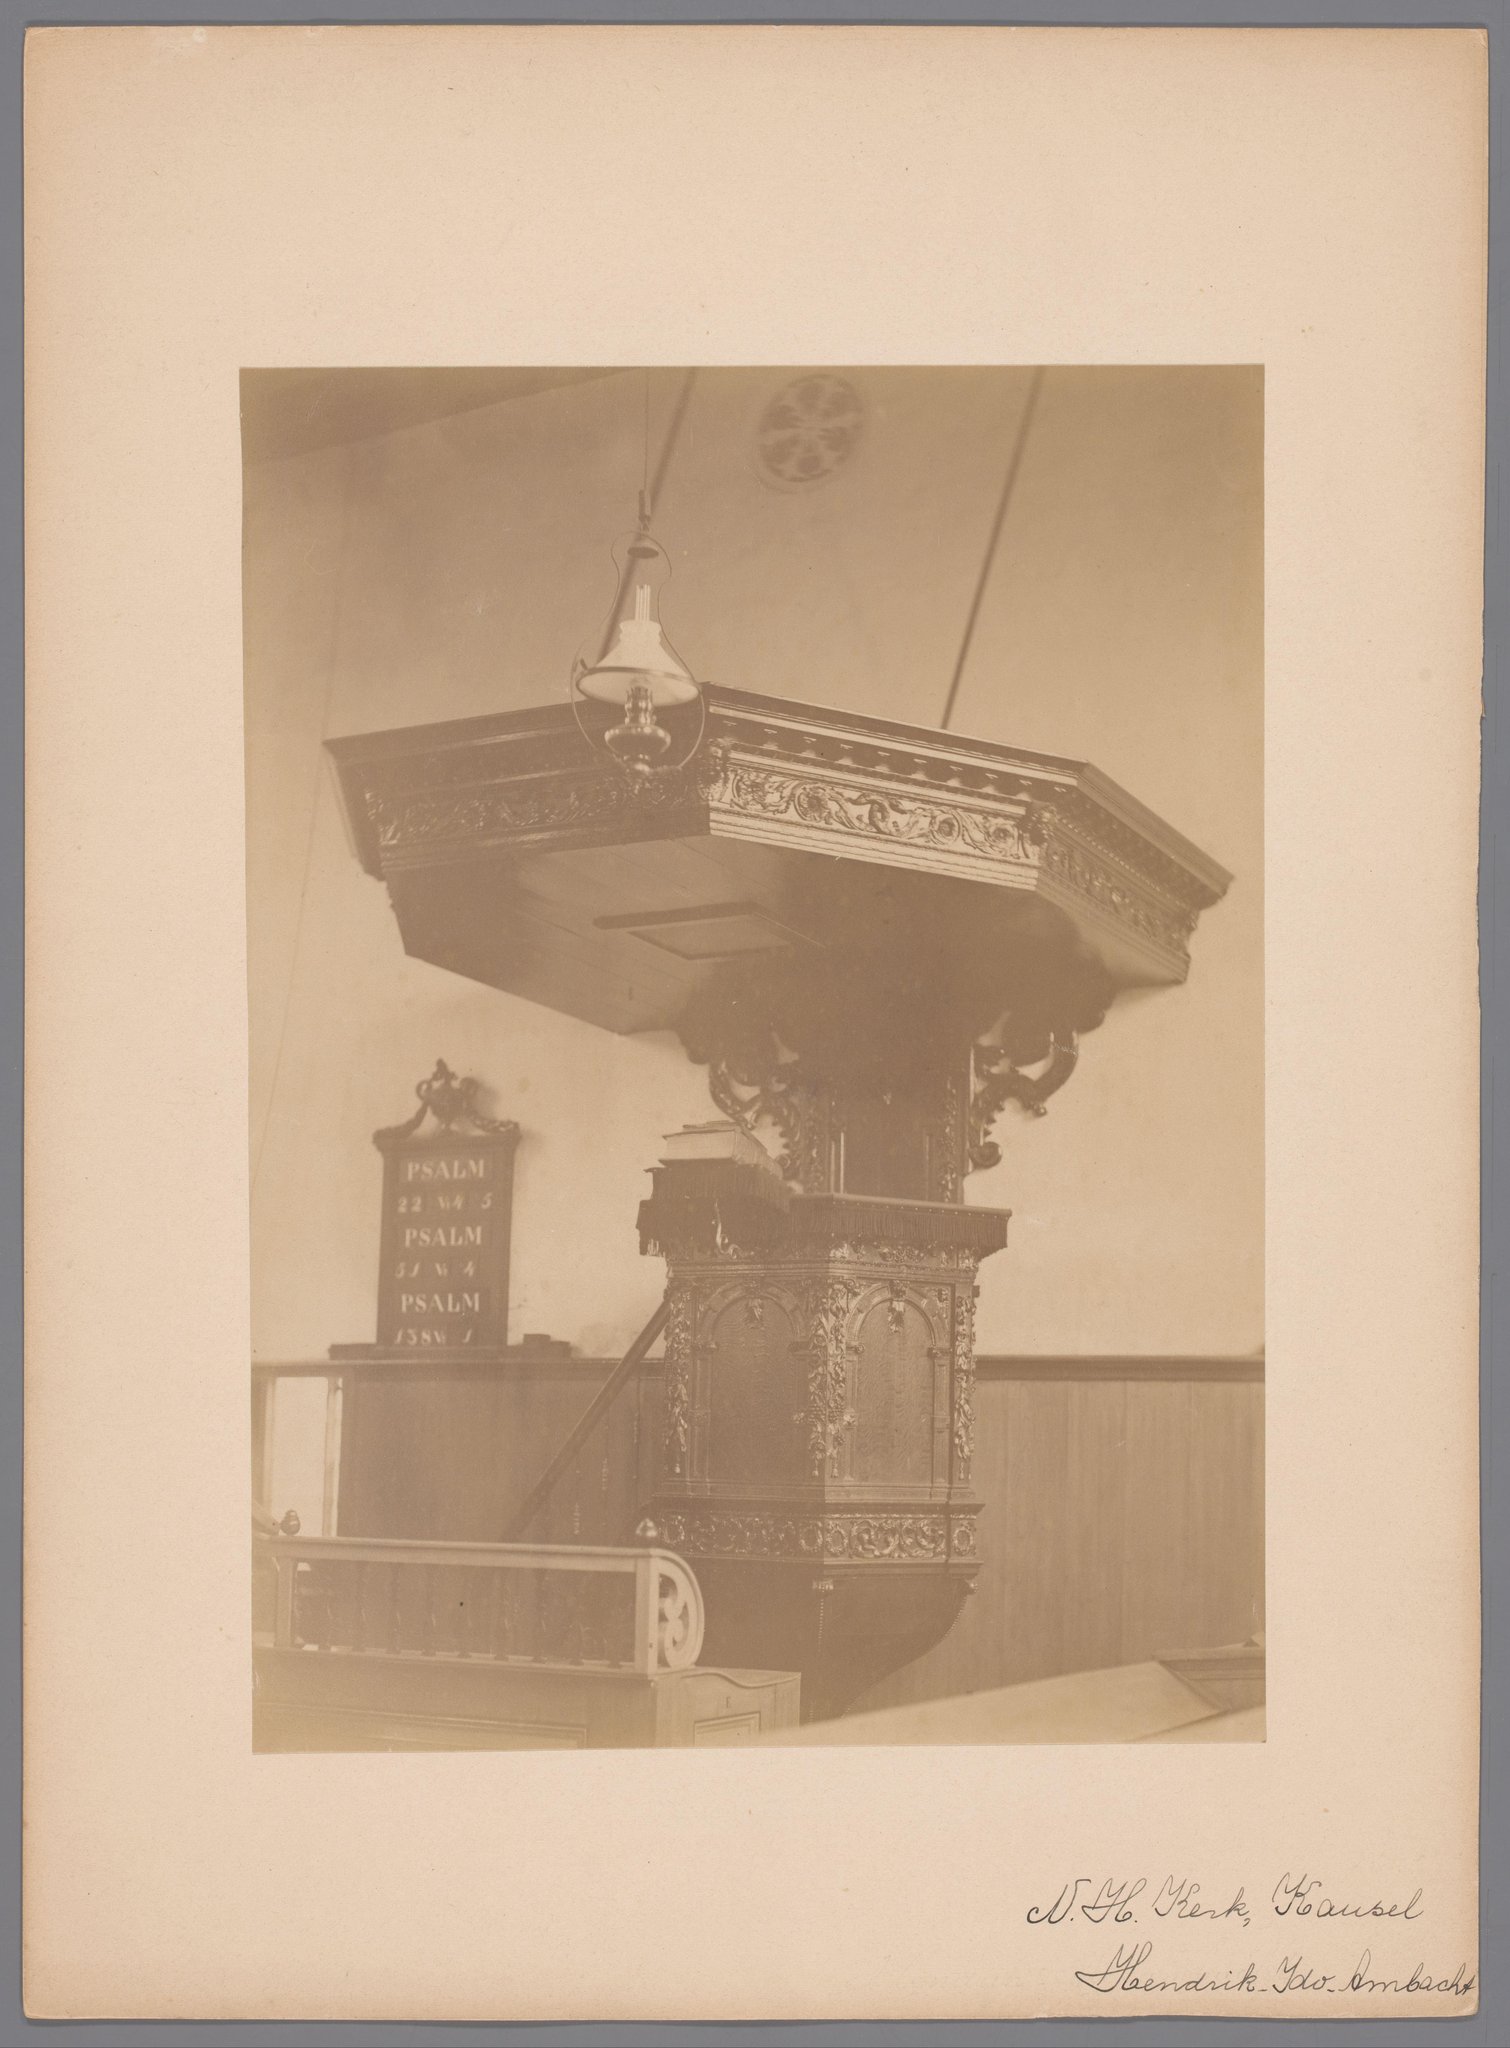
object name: photograph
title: Preekstoel in de Hervormde Kerk te Hendrik-Ido-Ambacht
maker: anoniem (monumentenzorg)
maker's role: fotograaf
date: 1890-1920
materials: cardboard, photographic support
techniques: albumen print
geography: hendrik-ido-ambacht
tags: interior of church, pulpit, ambo, chancel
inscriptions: annotation: ‘N.H. Kerk, Kansel/ Hendrik-Ido-Ambacht’